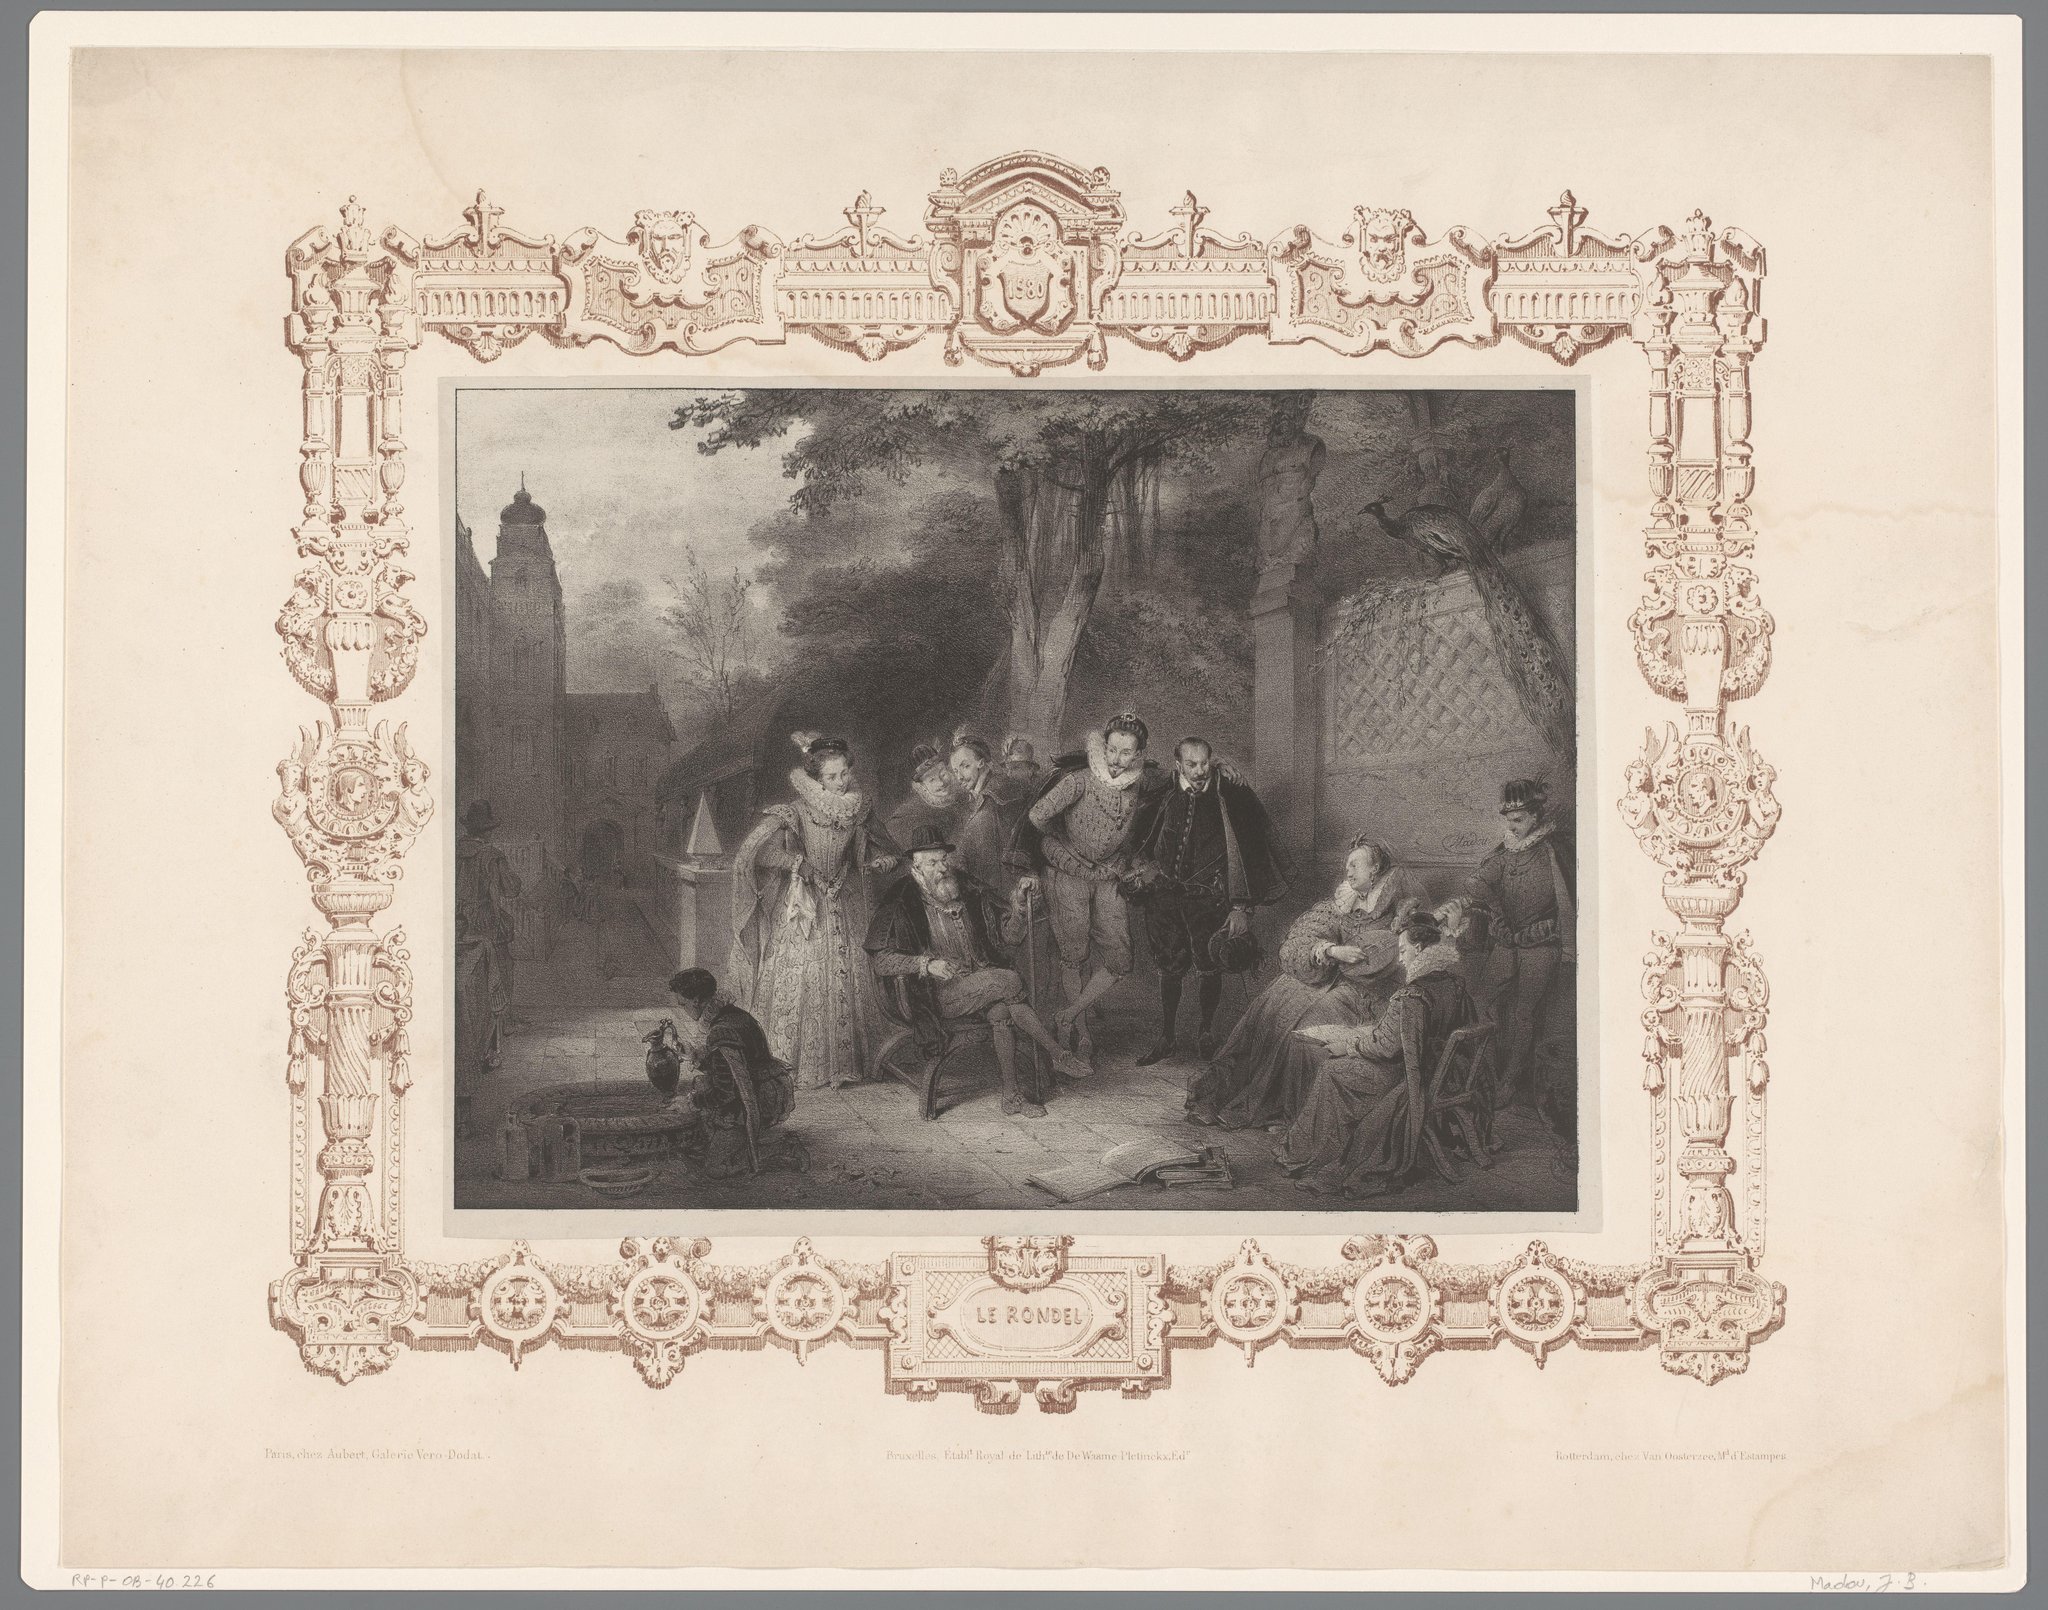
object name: print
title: Le rondel 1580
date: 1835-1837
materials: paper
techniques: lithograph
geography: brussels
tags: one person playing string instrument (plucked) - cc - out of doors, garden, banquet of elegant company - cc - out of doors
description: De voorstelling is vervaardigd door Madou, de omlijsting waarschijnlijk door Paulus Lauters en Philastre.